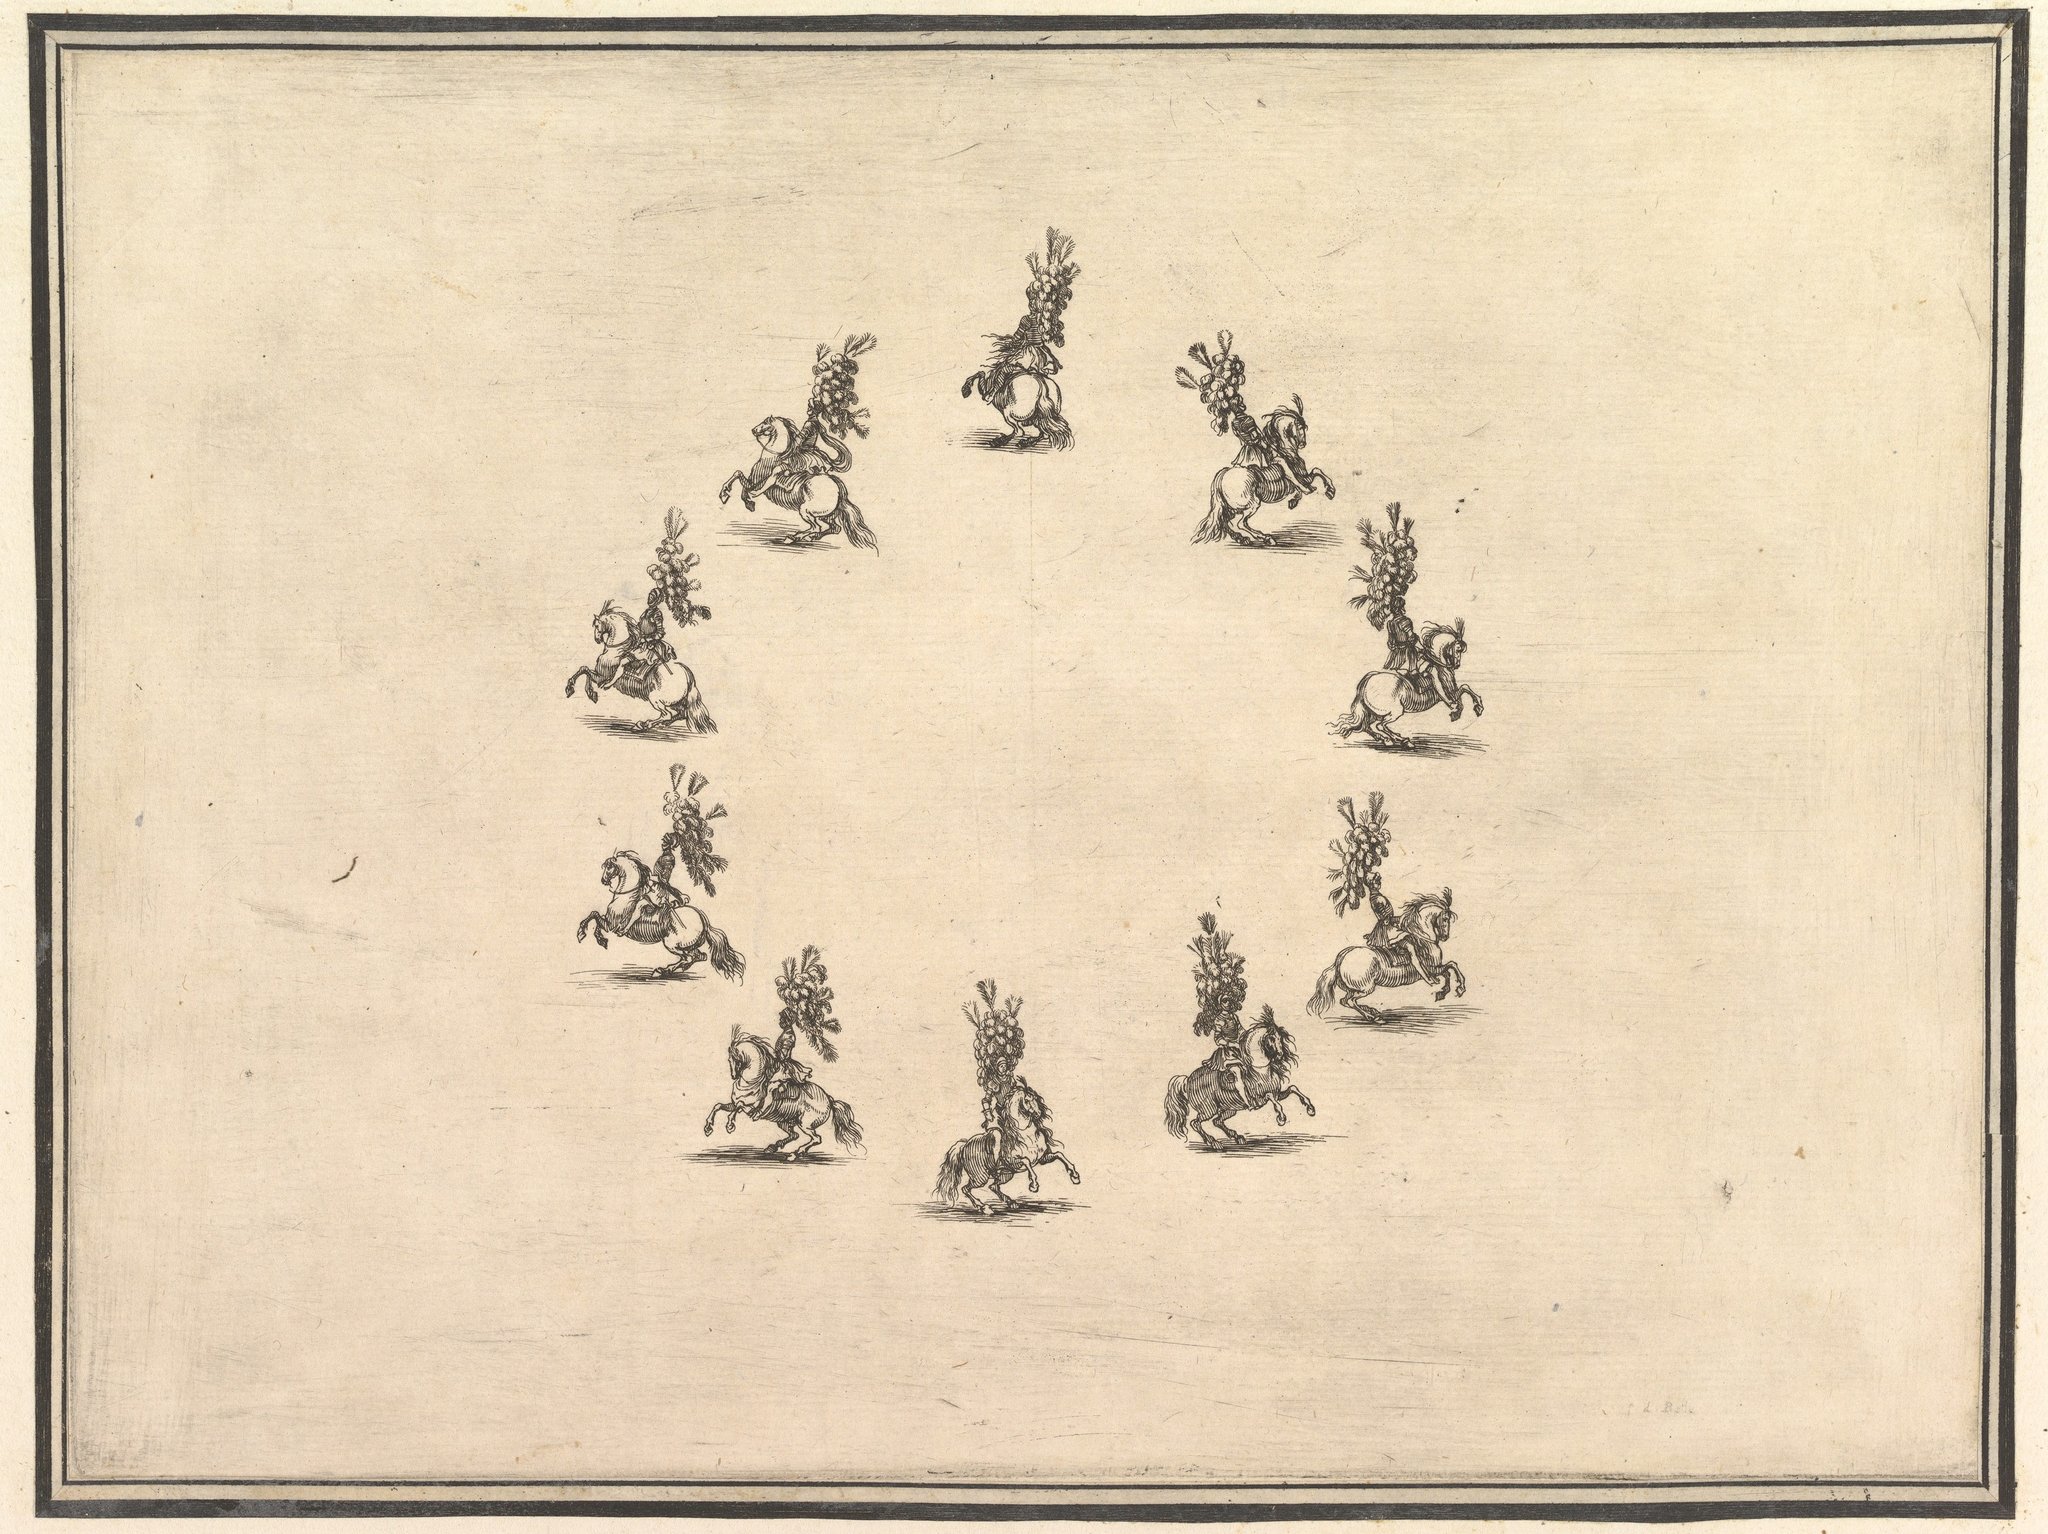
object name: print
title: Six riders forming a circle, from "La gara delle Stagioni"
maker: stefano della bella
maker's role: artist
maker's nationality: italian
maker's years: 1610-1664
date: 1652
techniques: etching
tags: human figures,horses